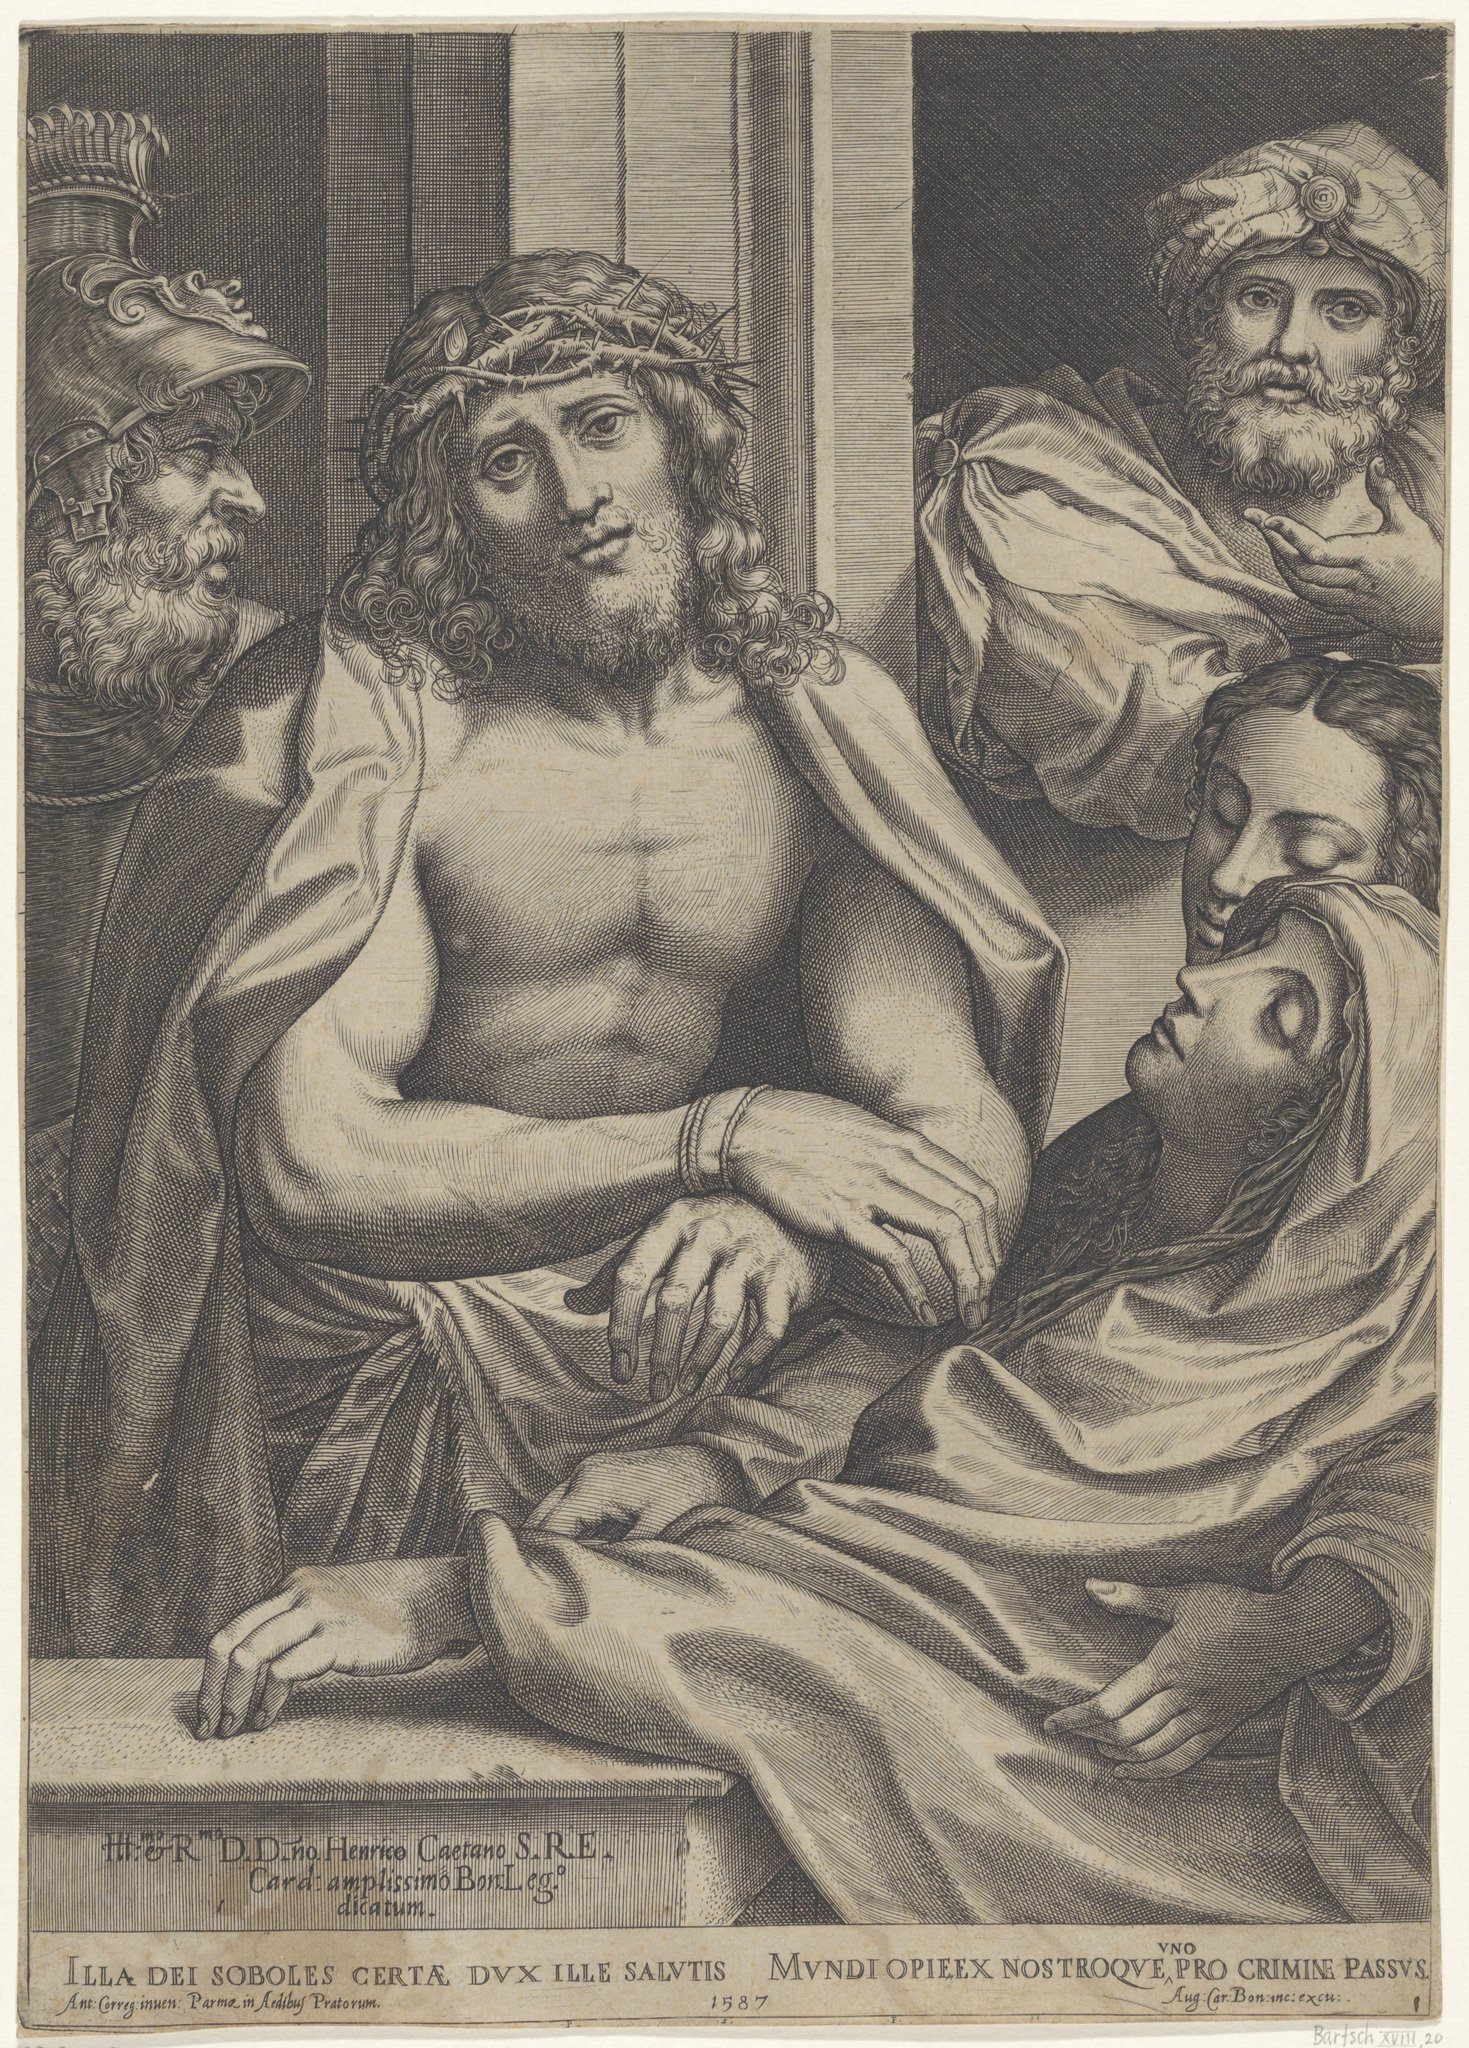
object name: print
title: Ecce Homo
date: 1587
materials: paper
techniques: engraving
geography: parma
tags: pilate showing christ to the people, 'ostentatio christi', 'ecce homo' (john 19:4-6)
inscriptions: collector's mark: Lugt 10, collector's mark: Lugt 11, number: ‘1’, collector's mark: ‘Hinloopen’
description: Christus, met doornenkroon en mantel, wordt aan het volk (in dit geval de beschouwer) getoond. Rechts staat Pontius Pilatus die naar Christus gebaart. Op de voorgrond bezwijkt Maria van verdriet en wordt ondersteund door een andere vrouw. Links een soldaat. Tekst in ondermarge.